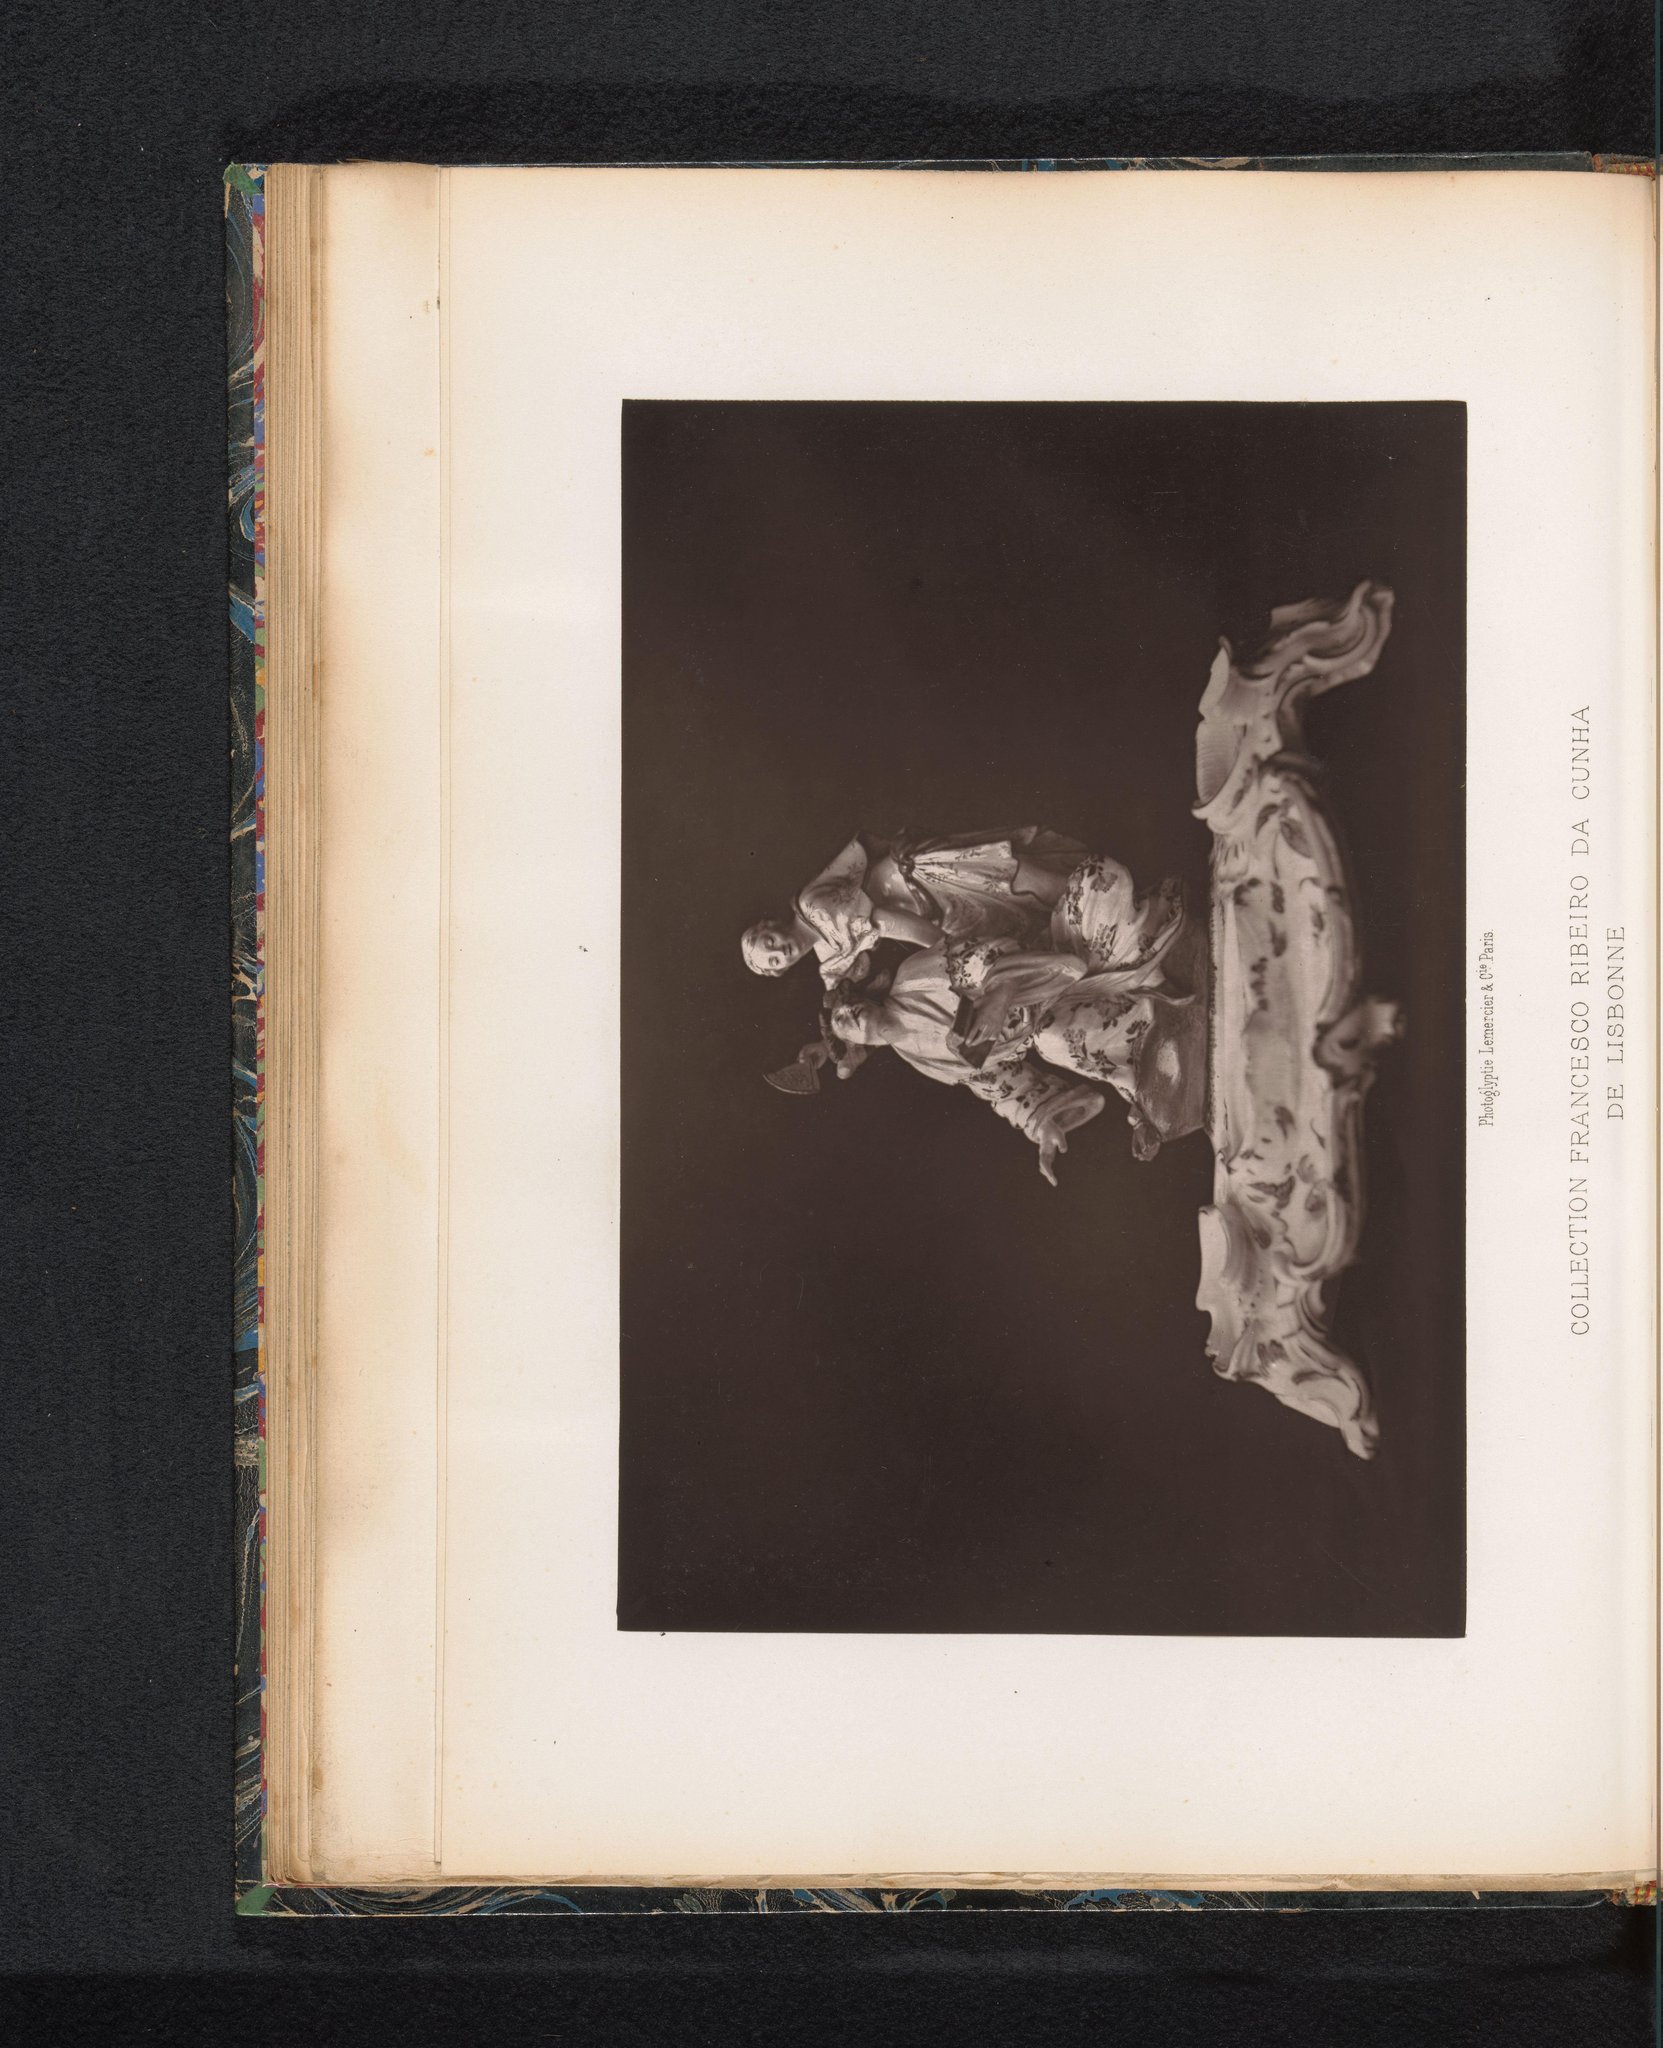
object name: photomechanical print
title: Twee figuren van Meissen porselein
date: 1879-1884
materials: paper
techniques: woodburytype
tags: the (nude) human figure; 'corpo humano' (ripa)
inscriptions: inscription: ‘Collection Francesco Riberio da Cunha de Lisbonne’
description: Prent op vierde ongenummerde pagina na pagina 28.